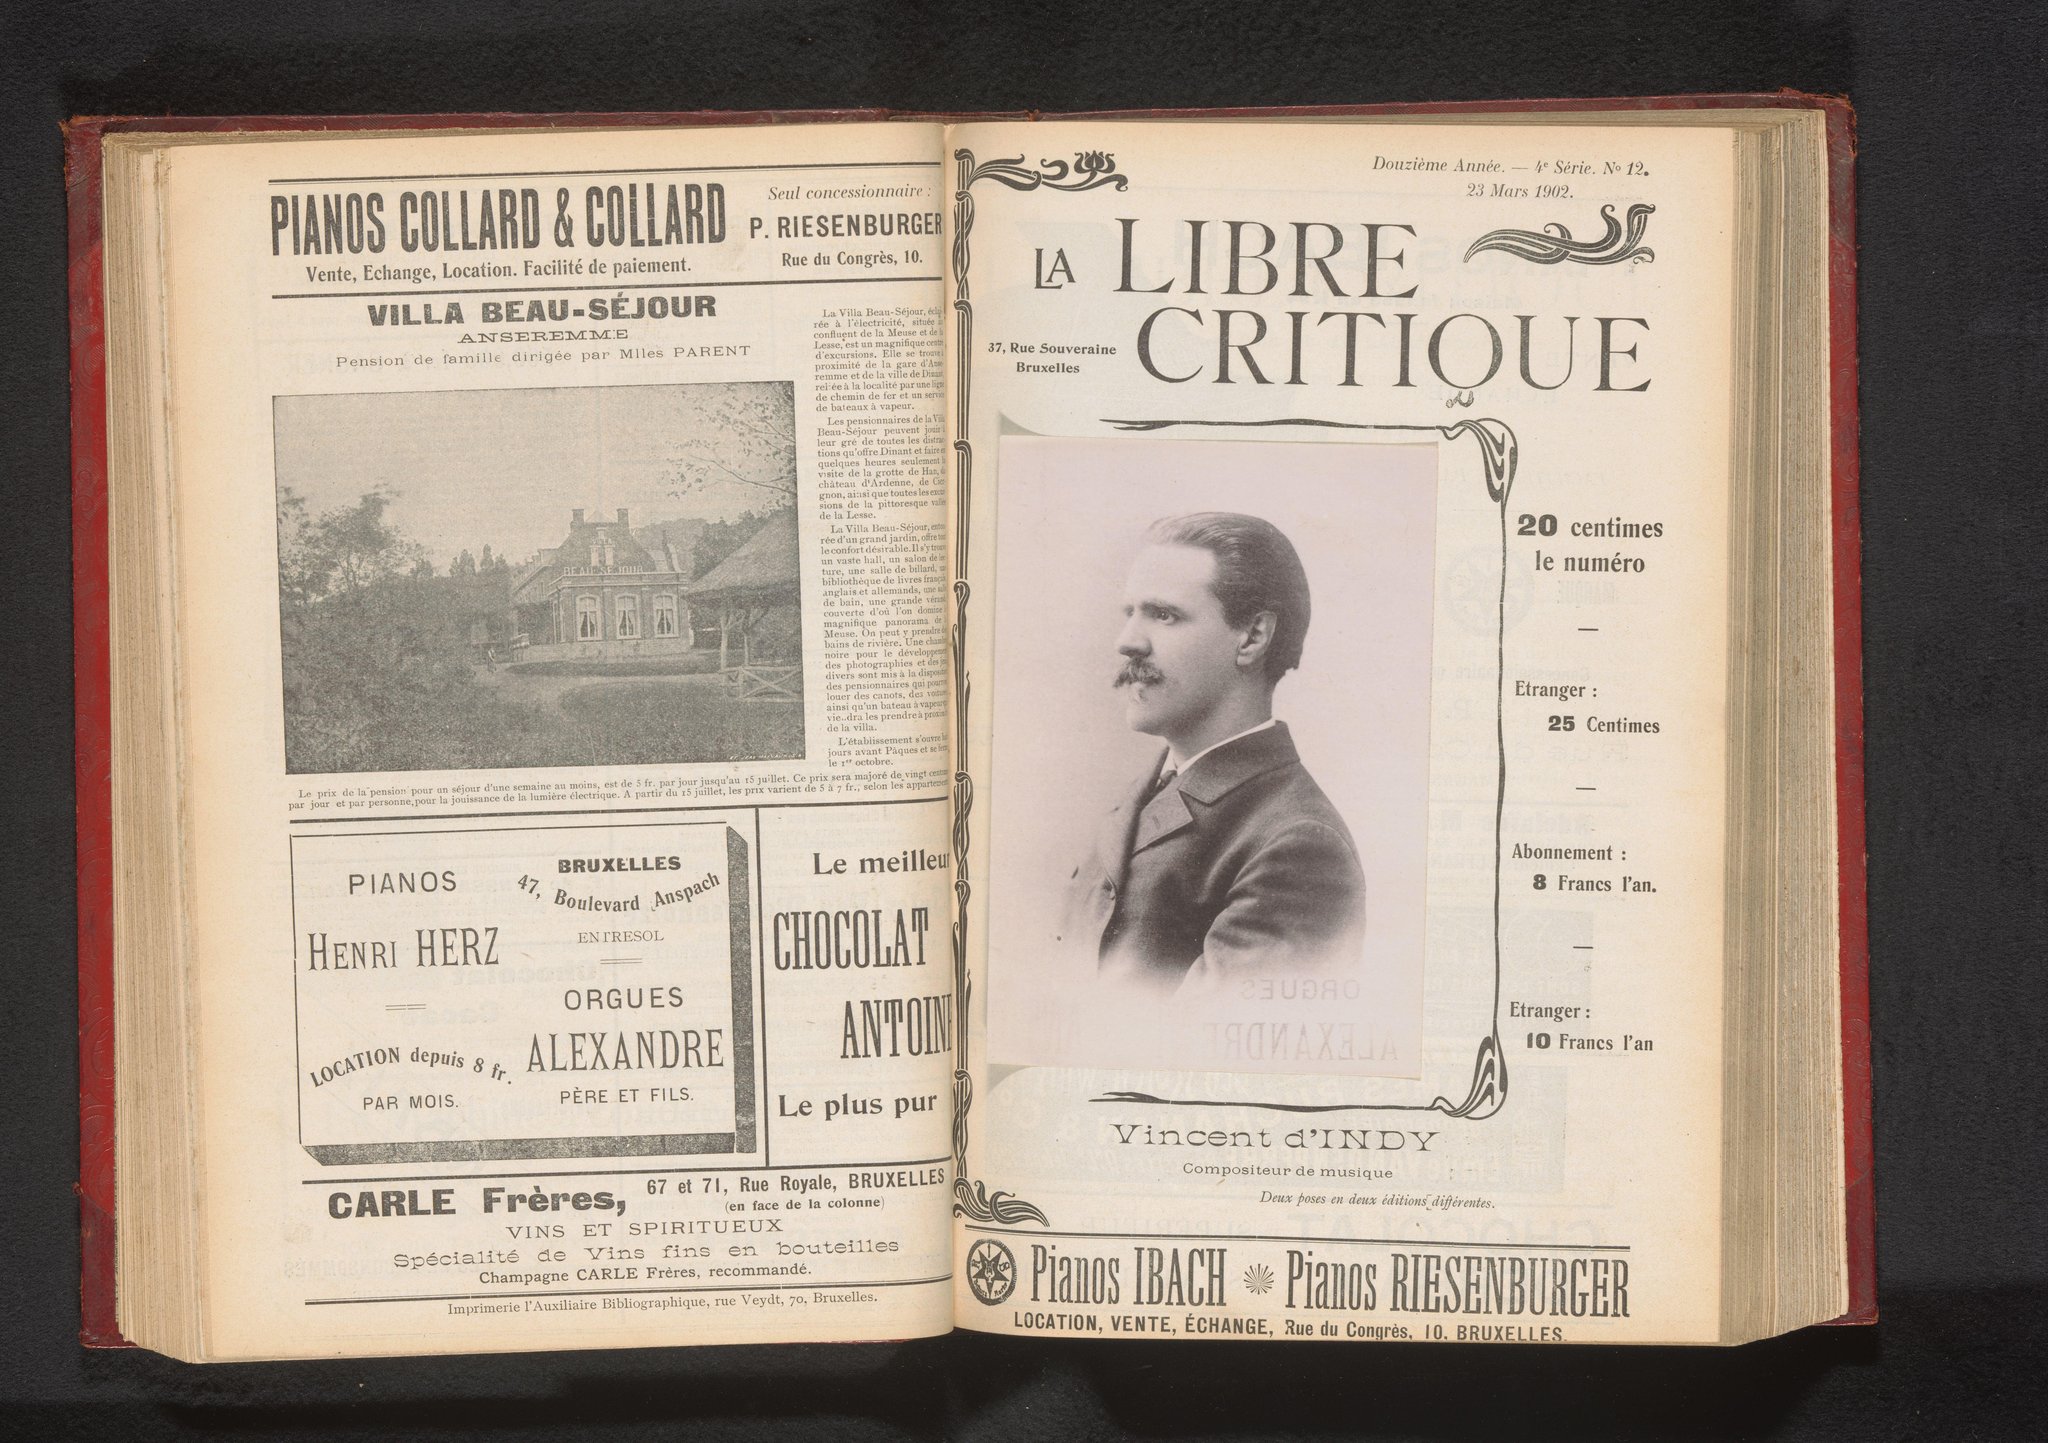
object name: page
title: Vincent d'Indy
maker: Anonymous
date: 1897-1902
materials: paper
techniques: photograph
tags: portrait of composer